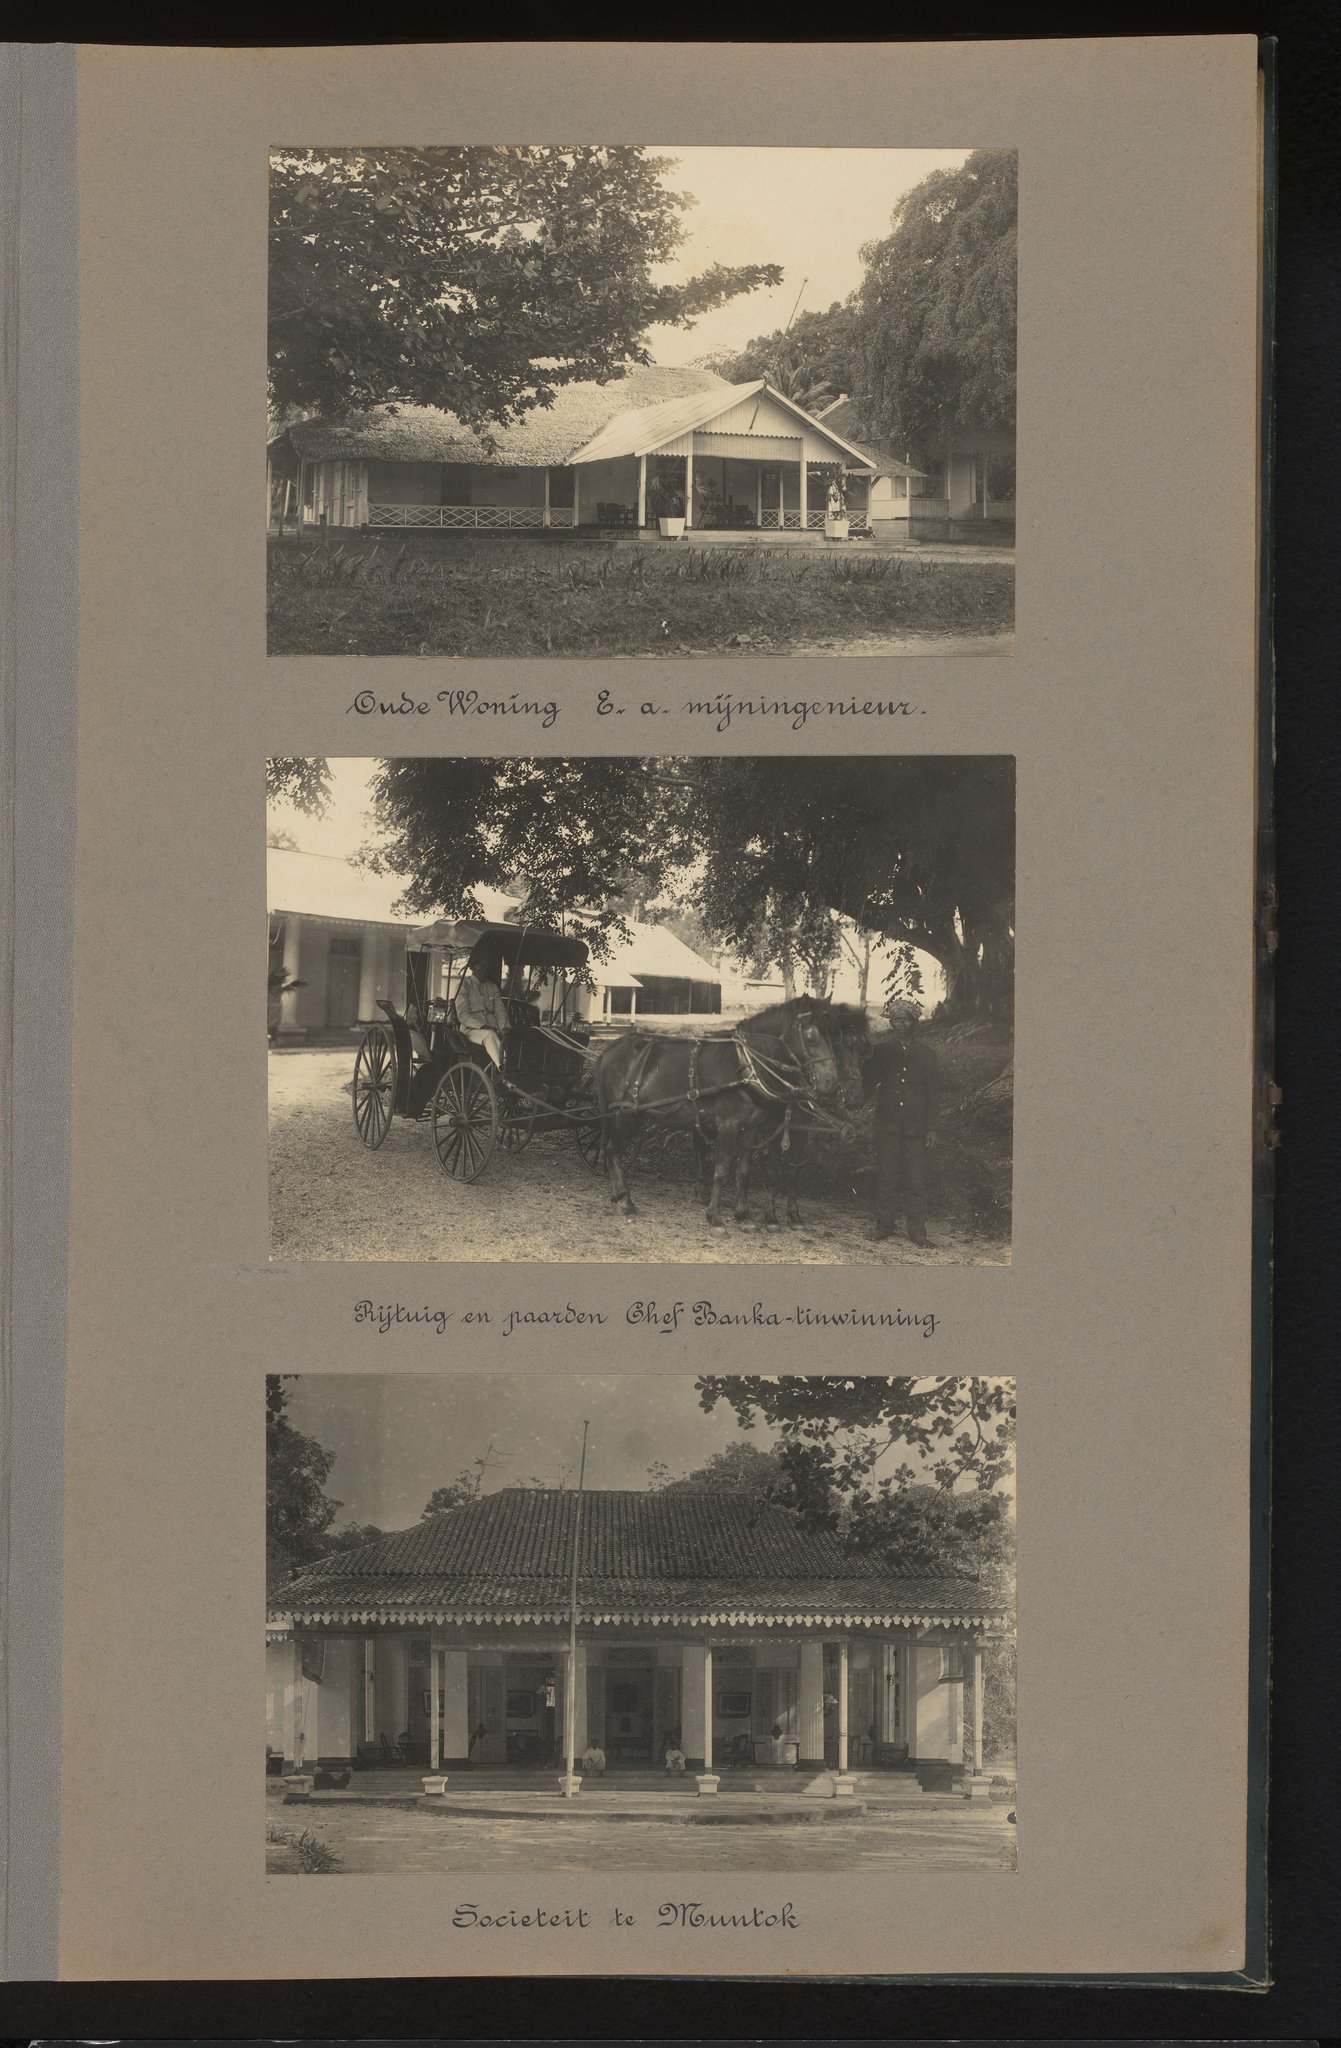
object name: album leaf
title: Woning, het rijtuig van de chef van het hoofdbureau van de Banka-tinwinning en de sociëteit te Muntok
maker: Anonymous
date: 1914-1919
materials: cardboard, photographic support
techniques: gelatin silver print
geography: bangka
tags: robert julius boers, colonial system, club, meeting place, mining, four-wheeled vehicle drawn by two animals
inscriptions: inscription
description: Albumblad met drie foto's van de oude woning van de mijningenieur, het rijtuig van de chef van het hoofdbureau van de Banka-tinwinning en de sociëteit te Muntok. Onderdeel van het fotoalbum aangeboden aan Robert Julius Boers bij zijn vertrek naar Nederland in 1919 door het personeel van de Banka-tinwinning.